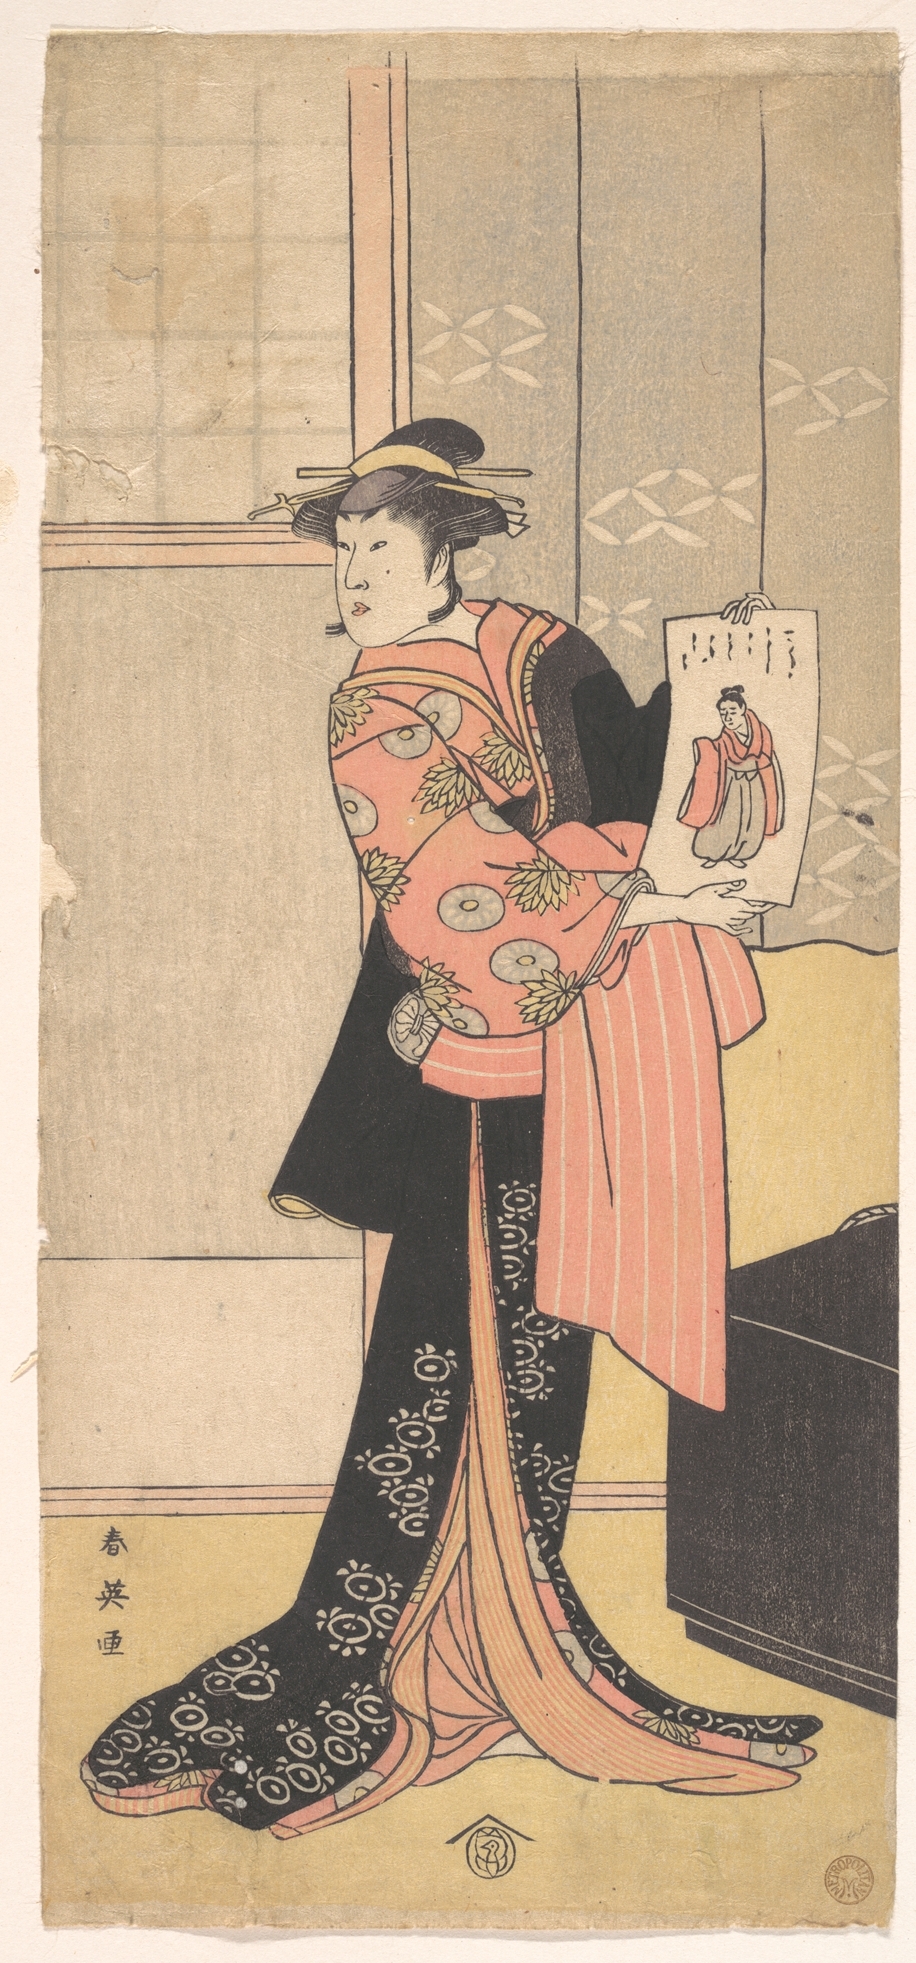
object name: print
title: The Third Segawa Kikunojo as a Woman Standing in a Room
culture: japanese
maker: katsukawa shun'ei 勝川春英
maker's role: artist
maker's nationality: japanese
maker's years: 1762-1819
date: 1793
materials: ink, paper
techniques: woodblock print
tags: women,actors